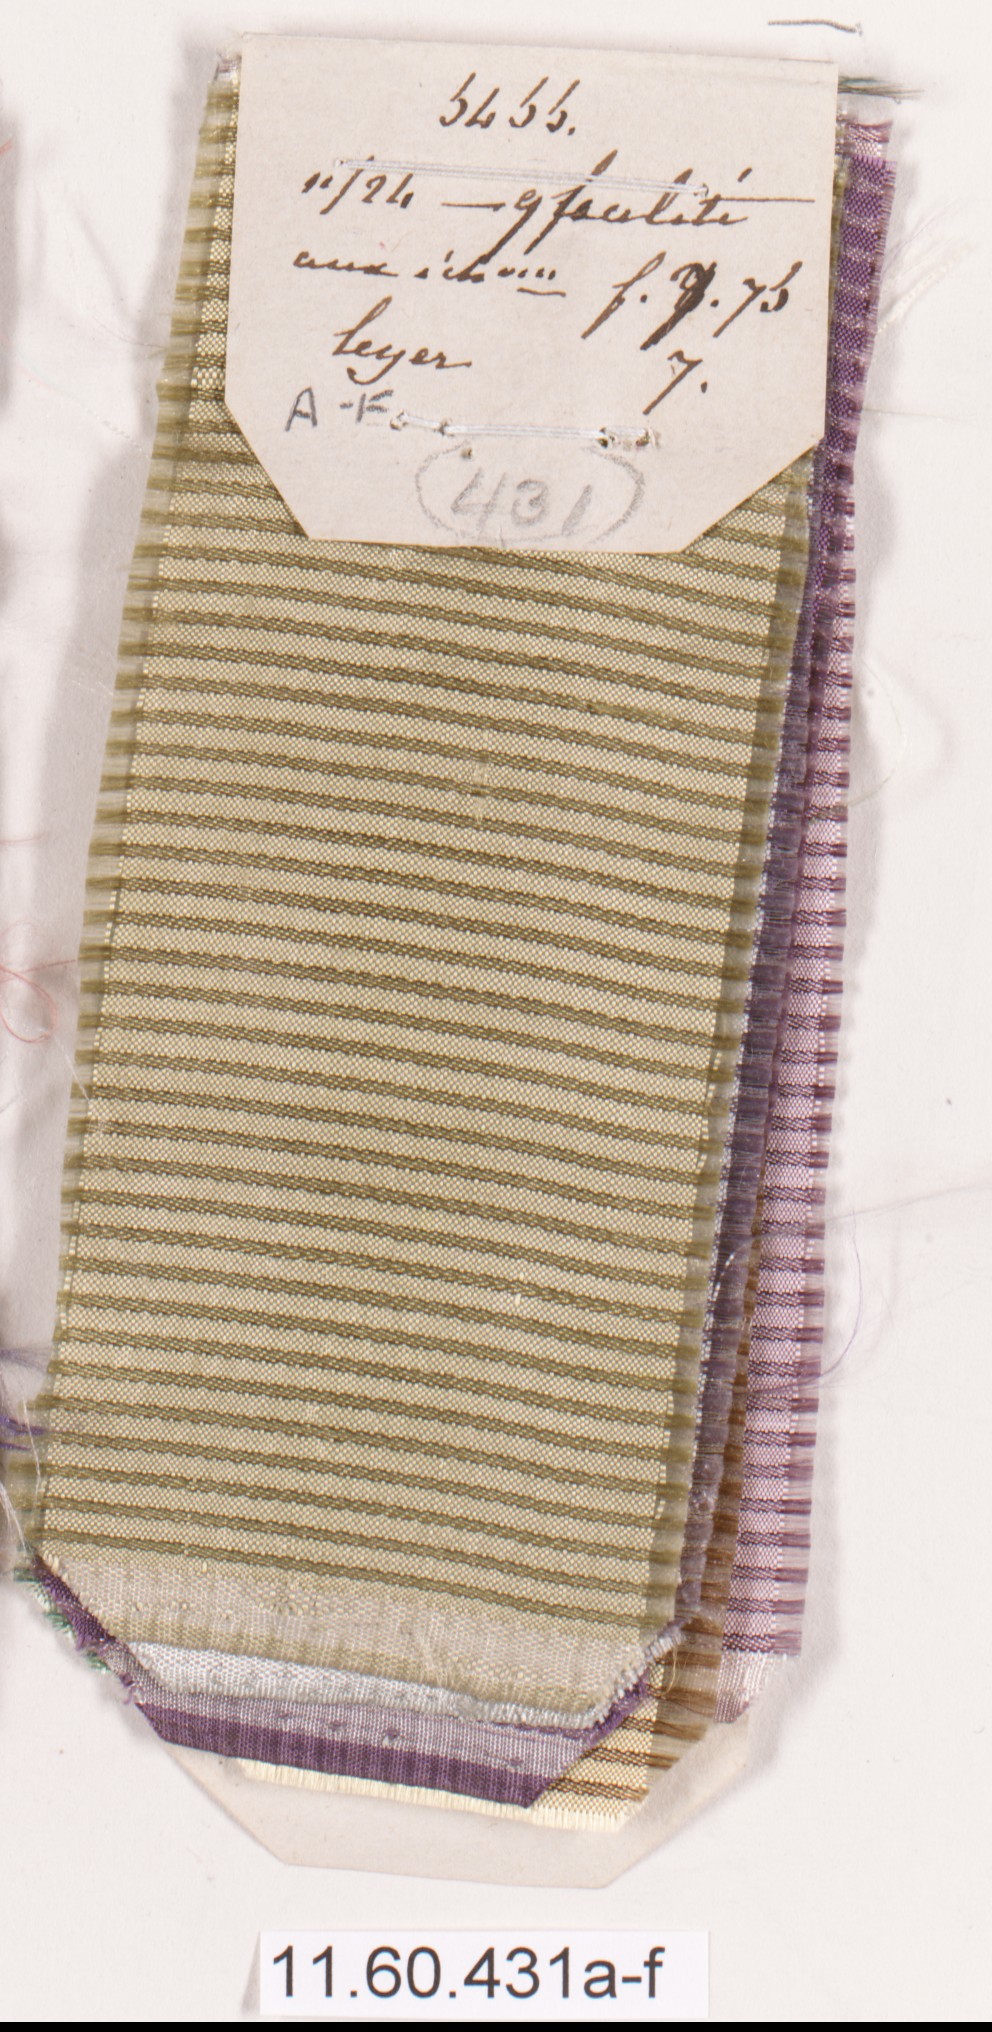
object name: fragment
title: Fragments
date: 1801-1900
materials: silk